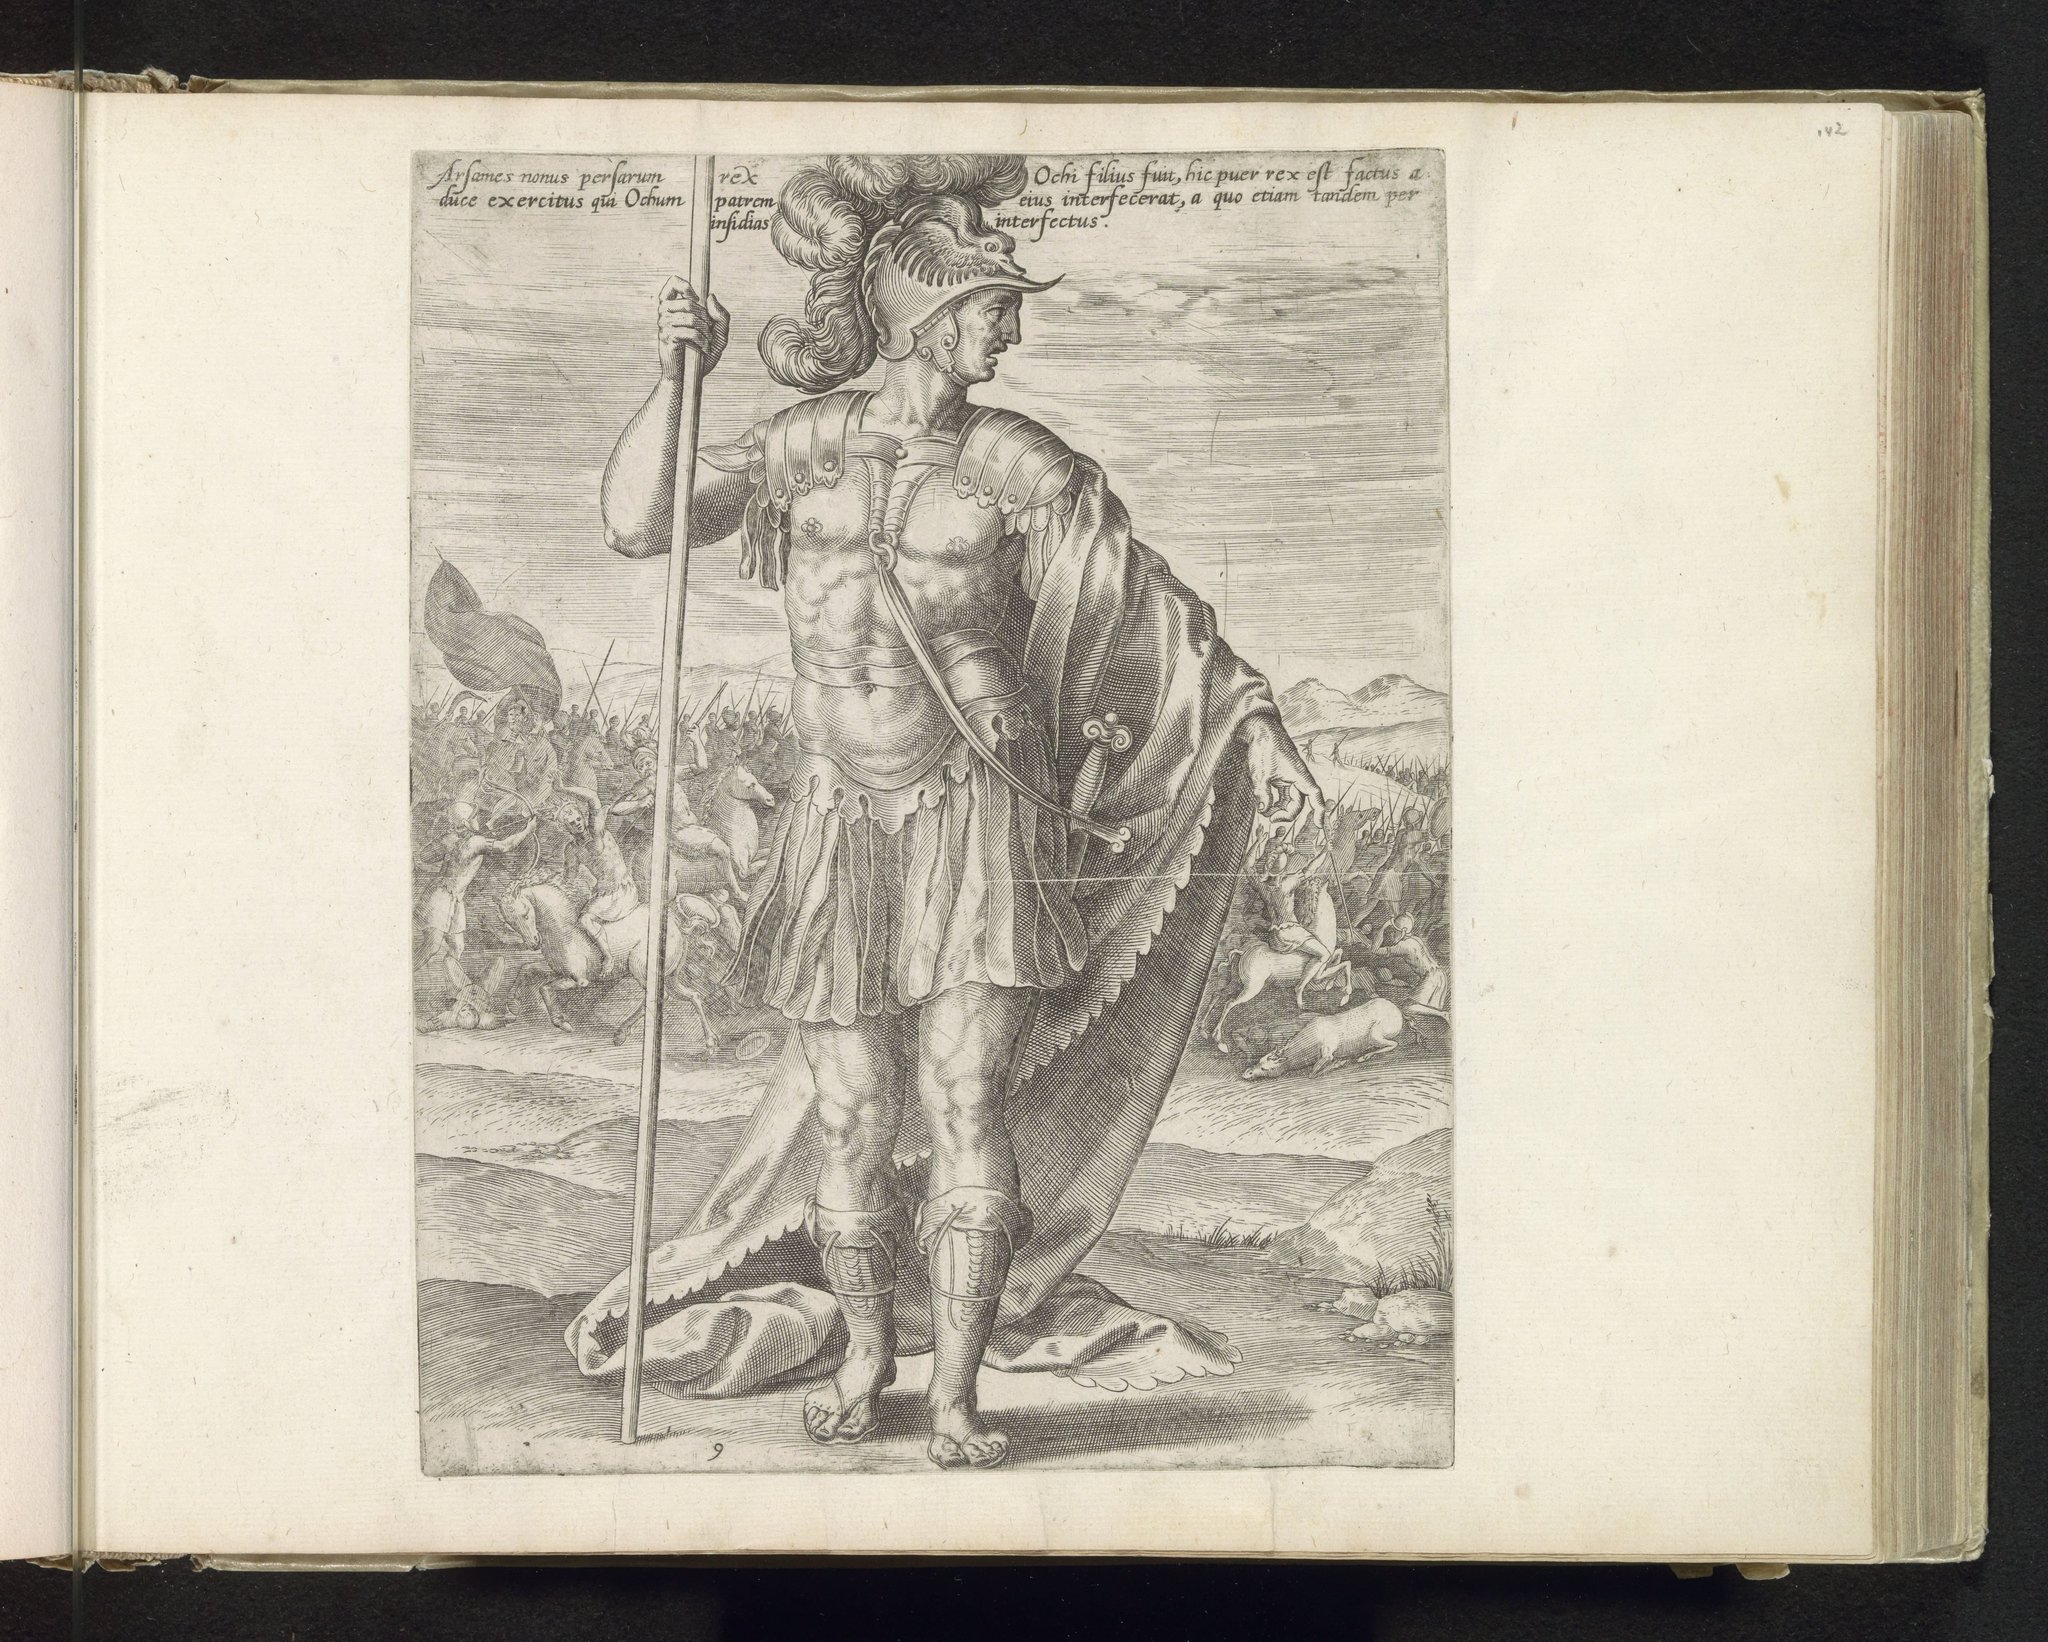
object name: album leaf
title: Koning Arsames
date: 1585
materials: paper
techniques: engraving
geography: antwerp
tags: battle, male persons from classical history, ruler, sovereign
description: Koning Arsames van Perzië staande met lange staf of lans in zijn hand. Op de achtergrond een veldslag. Boven de voorstelling een drieregelige tekst in het Latijn. Deze prent maakt deel uit van een album.